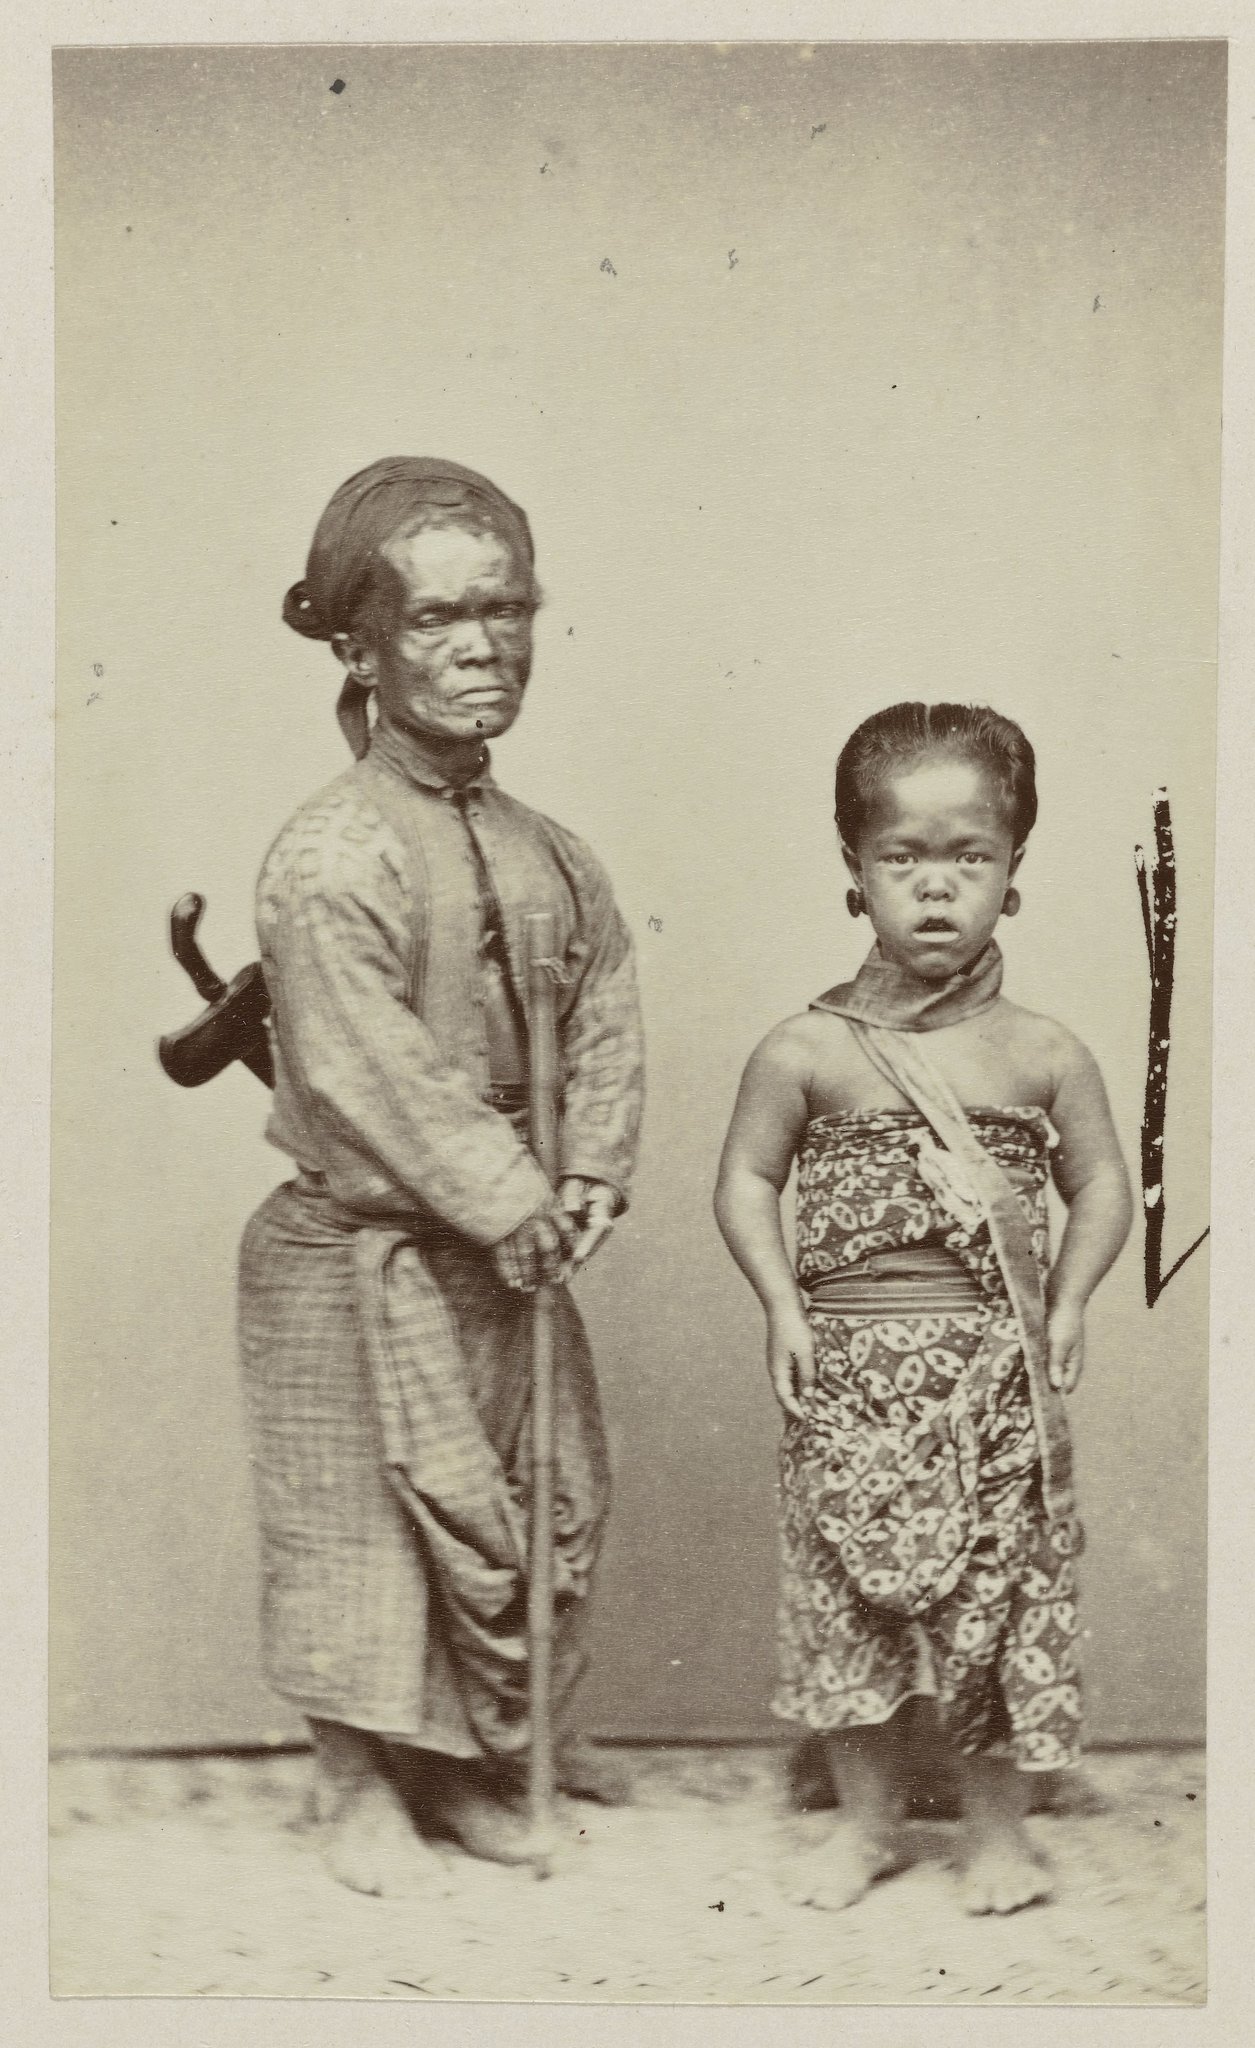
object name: photograph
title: Portret van twee kleine mensen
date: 1860-1880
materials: photographic support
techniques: albumen print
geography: batavia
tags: little people - aa - female human figure, historical persons not known by name - bb - woman, little people, historical persons not known by name, java, batavia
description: Studioportret van twee kleine mensen (dwergen), waarschijnlijk te Batavia. Ingeplakte foto in het fotoalbum getiteld: Gezichten van Java.